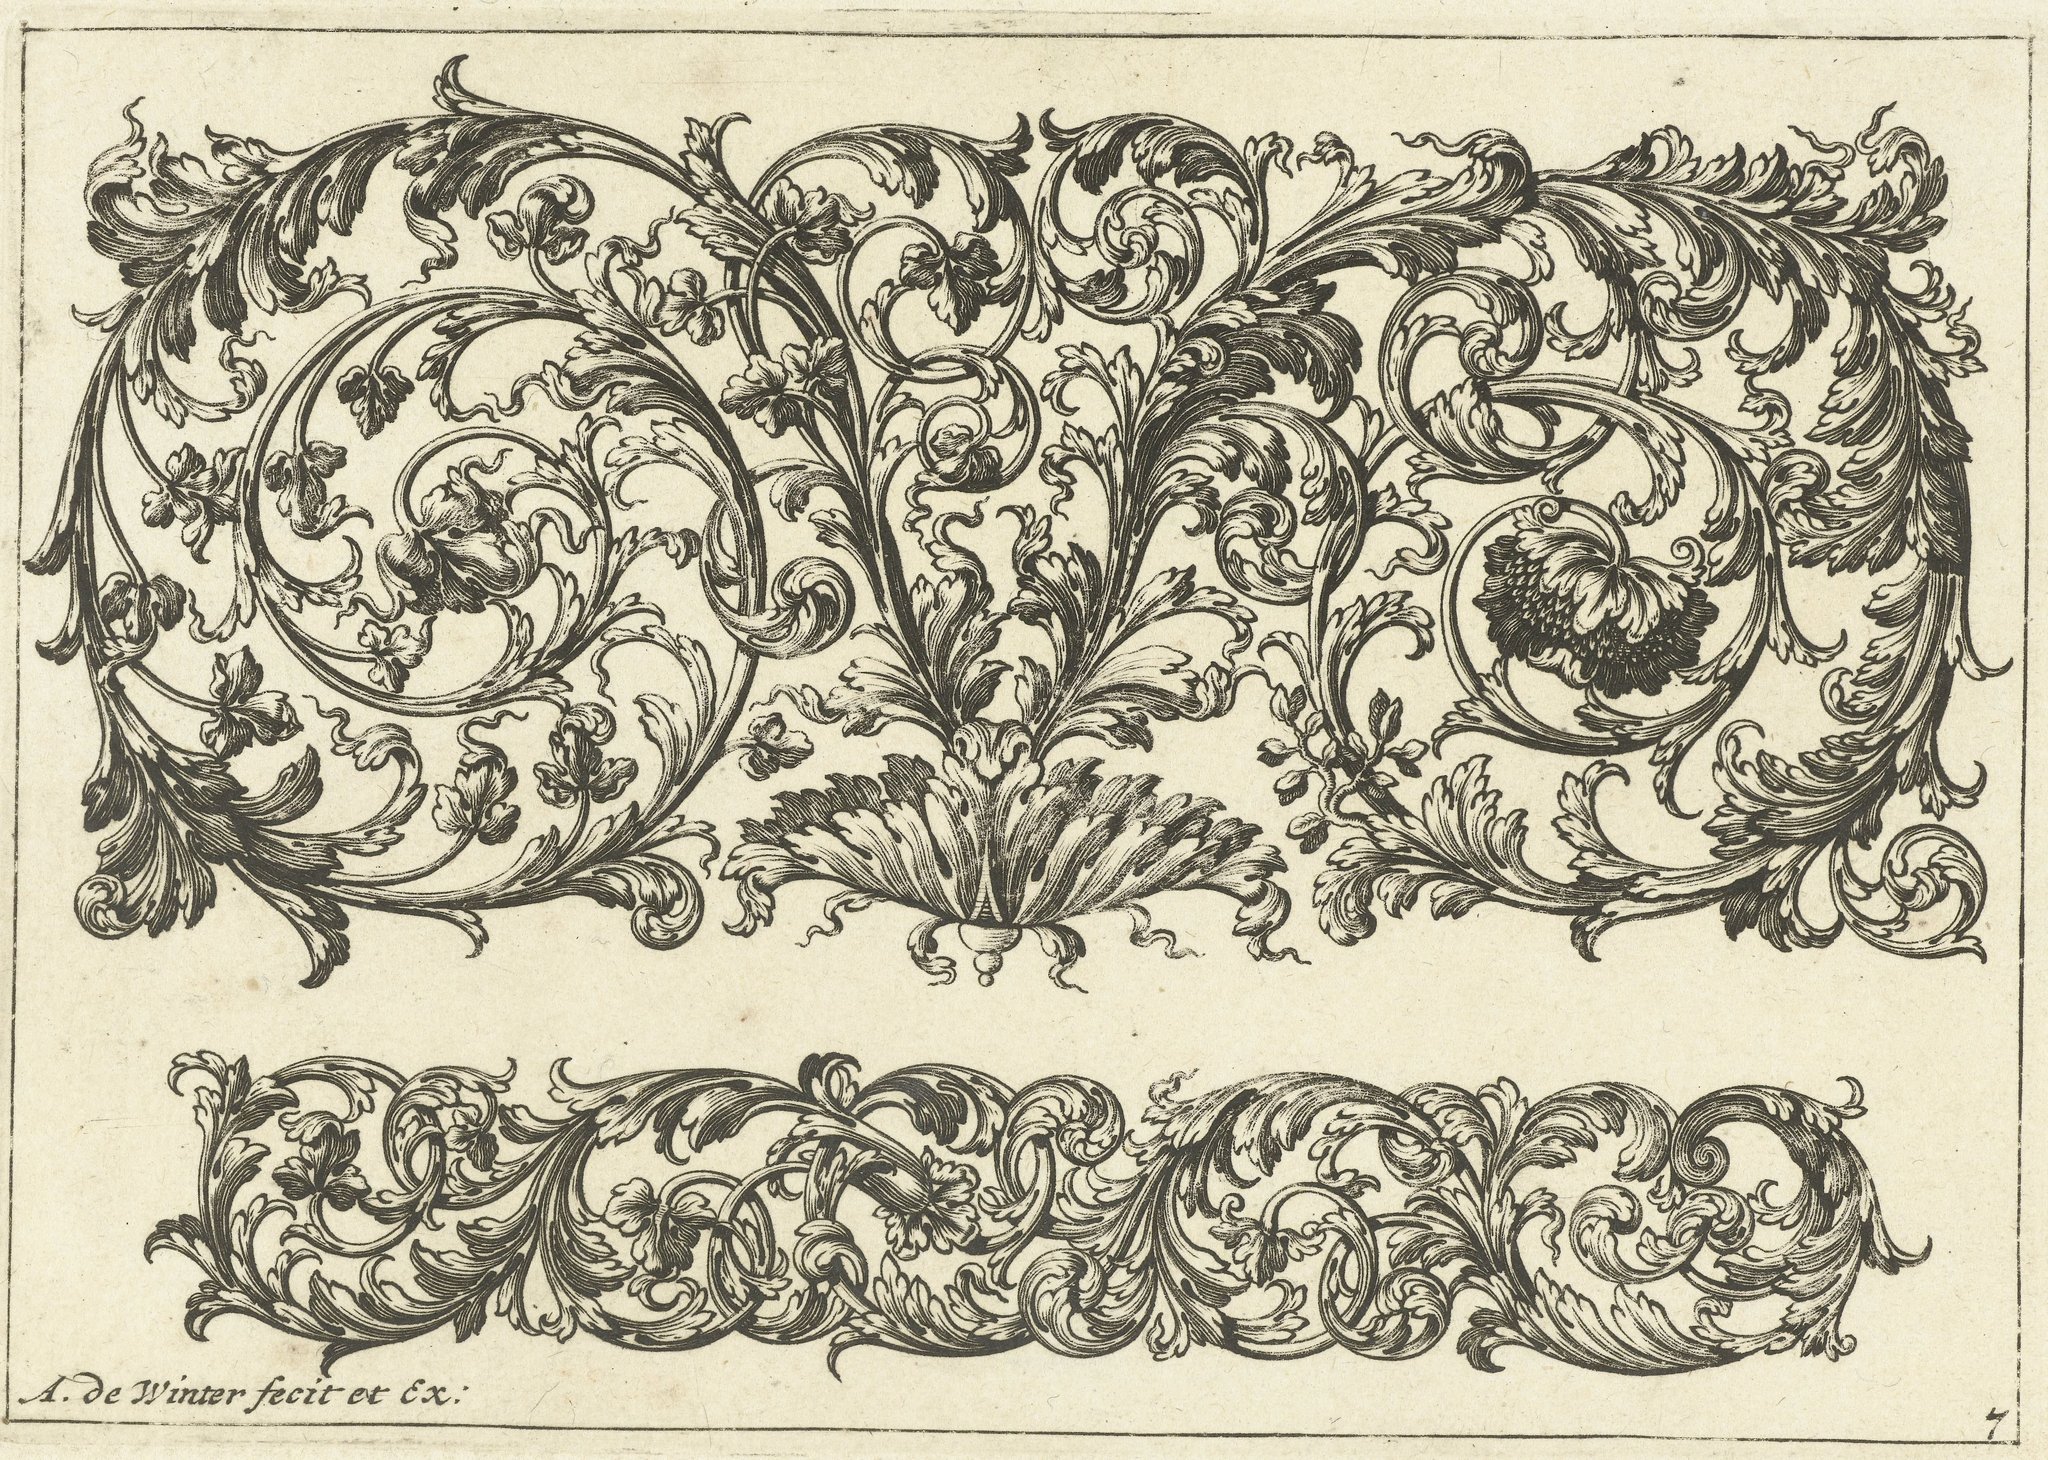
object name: print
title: Nouveau Livre d'Ornemens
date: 1690-1700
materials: paper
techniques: engraving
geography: amsterdam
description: Bovenaan ontspruit een dubbele bladrank uit een rozet. Blad uit serie met kopieën naar Stefano della Bella, Gilles Légaré, Thomas Lejuge en anderen.